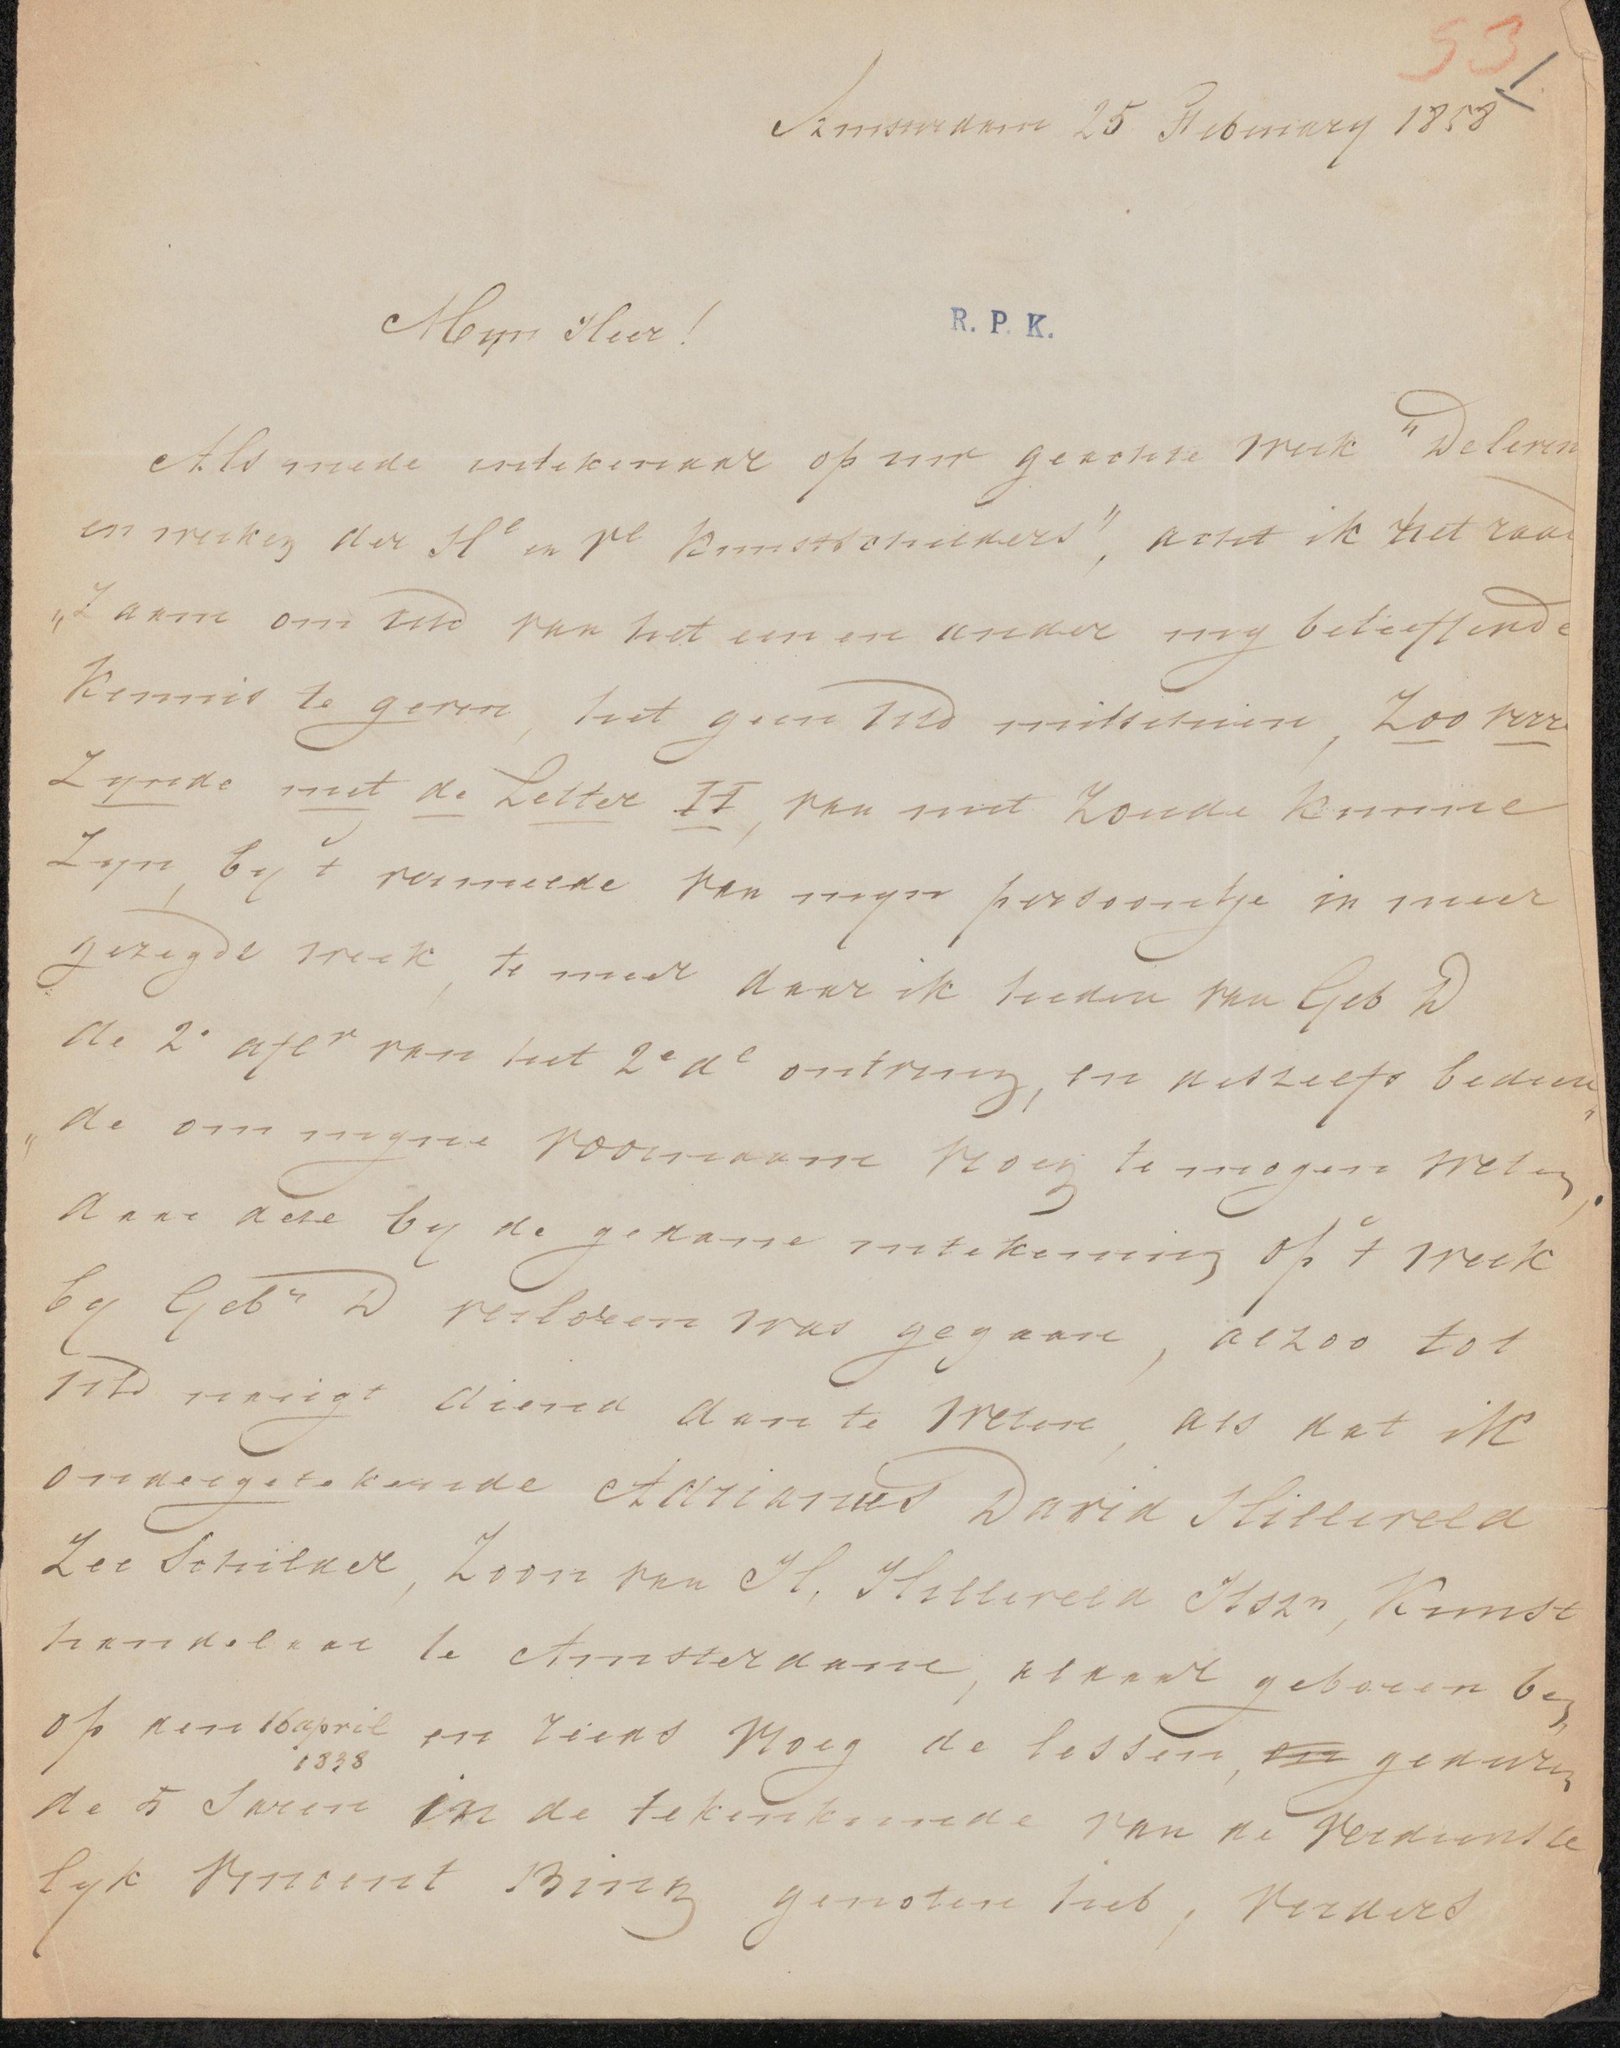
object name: letter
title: Brief aan Christiaan Kramm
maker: adrianus david hilleveld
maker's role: painter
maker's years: 1838-1889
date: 1858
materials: ink, paper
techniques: pen, writing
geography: amsterdam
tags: h. hilleveld hzn, london, print maker, draughtsman, abraham hulk, utrecht, christiaan kramm, drawing, education, tuition of the artist (in general), painting (including book-illumination, miniature-painting), exhibition ~ art, brussels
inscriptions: collector's mark: Lugt 2233